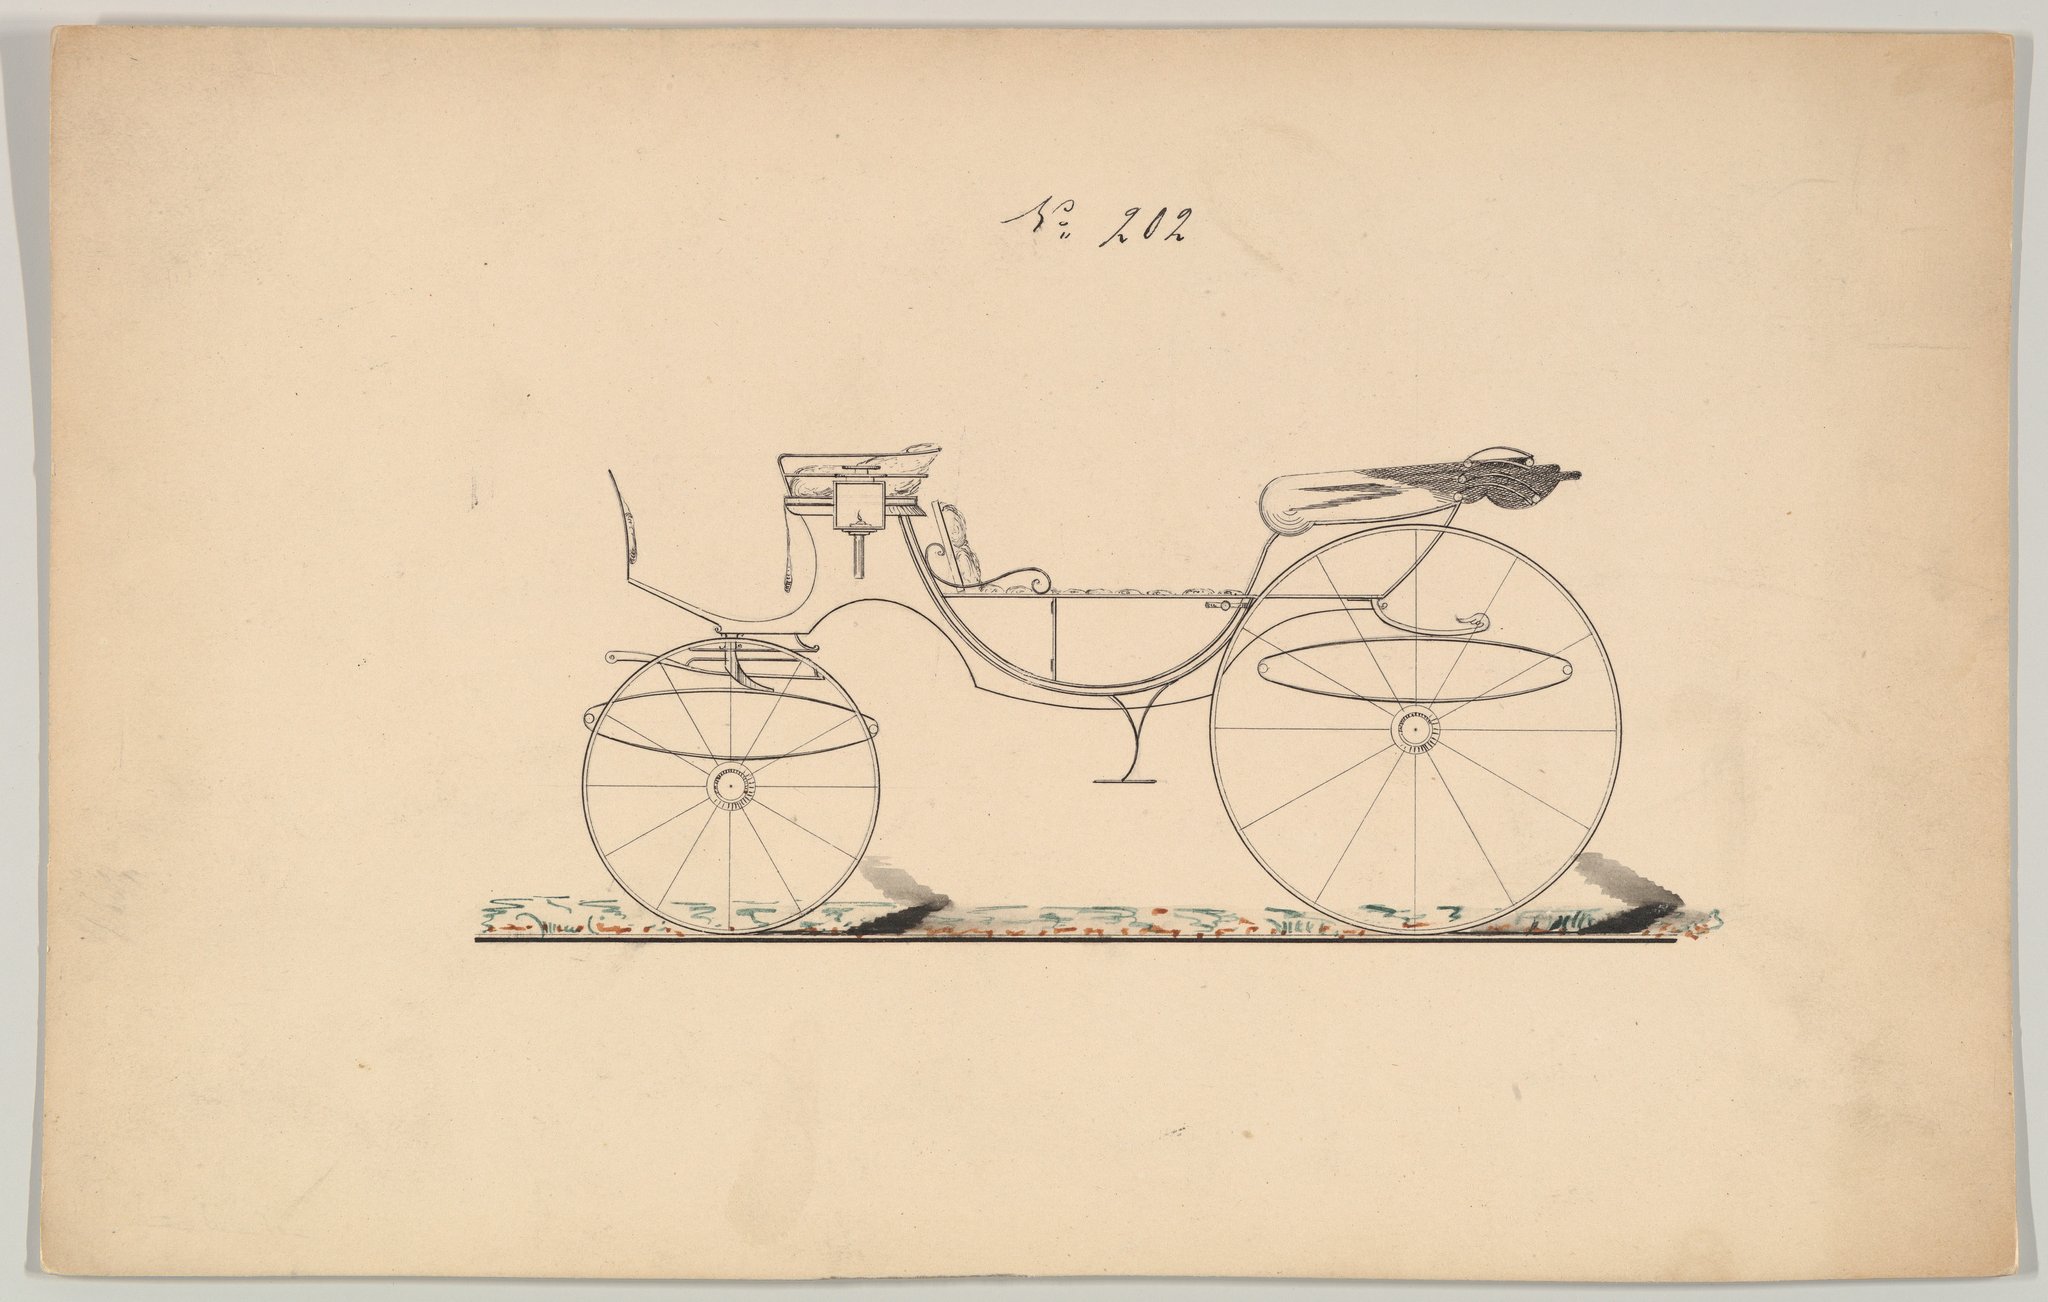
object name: drawing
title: Design for Vis-à-vis, no. 202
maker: brewster & co.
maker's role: manufacturer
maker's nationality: american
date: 1850-1870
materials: gouache, ink, watercolor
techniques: pen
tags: carriages